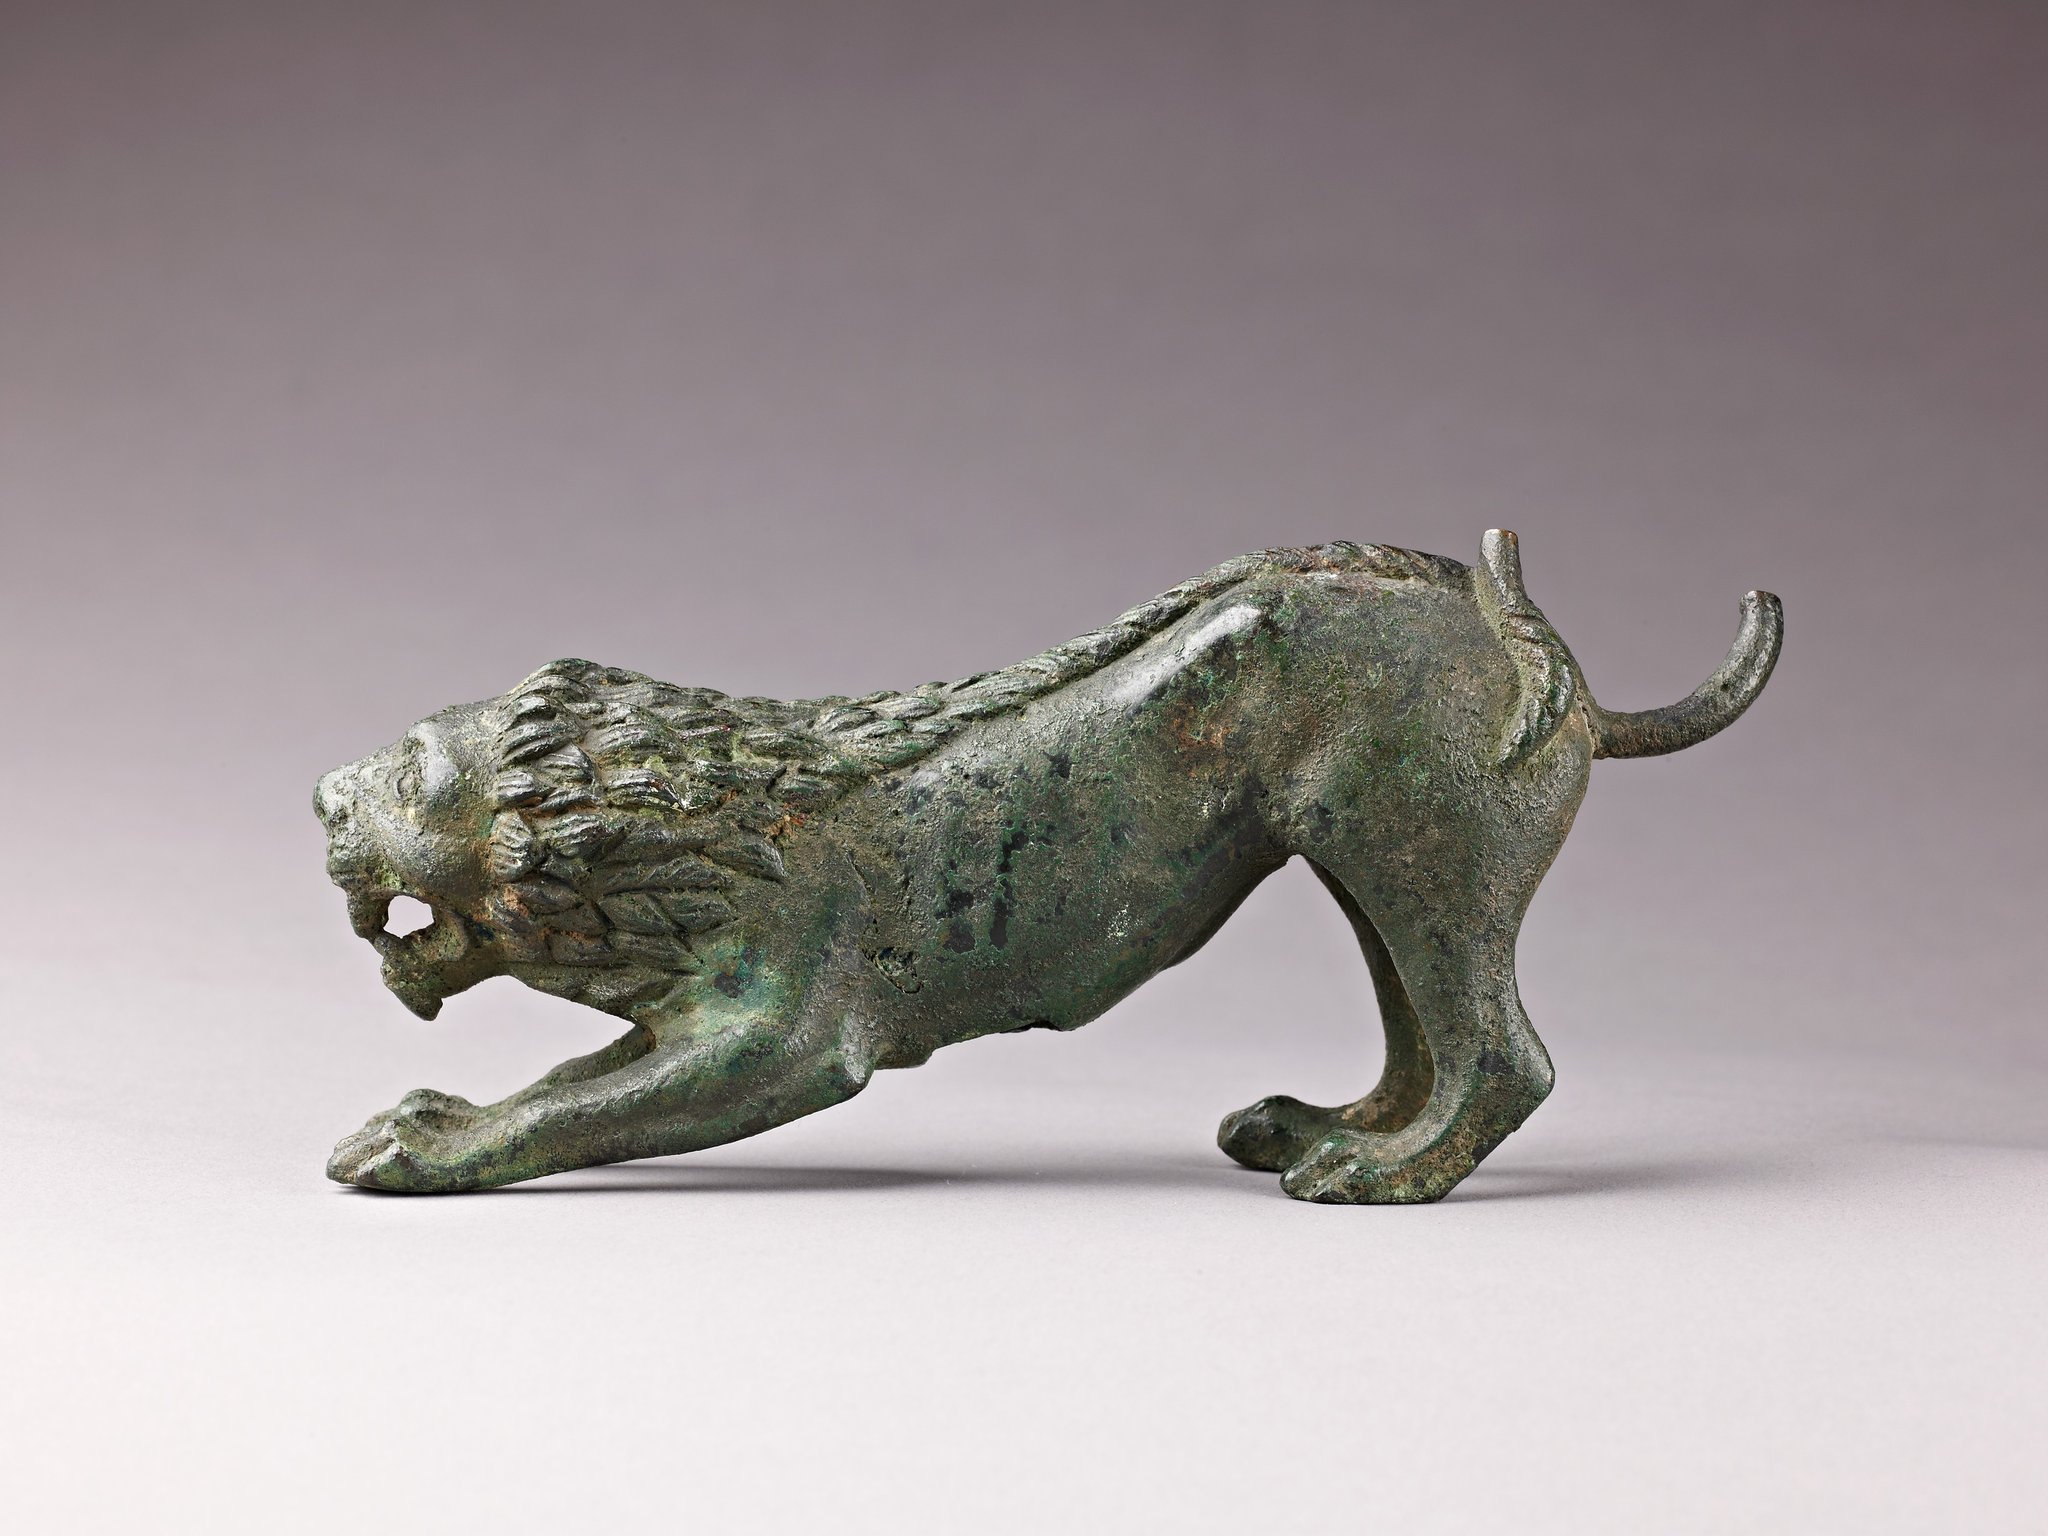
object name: sculpture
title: Crouching Lion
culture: roman republican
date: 500-201 BCE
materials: bronze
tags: lions